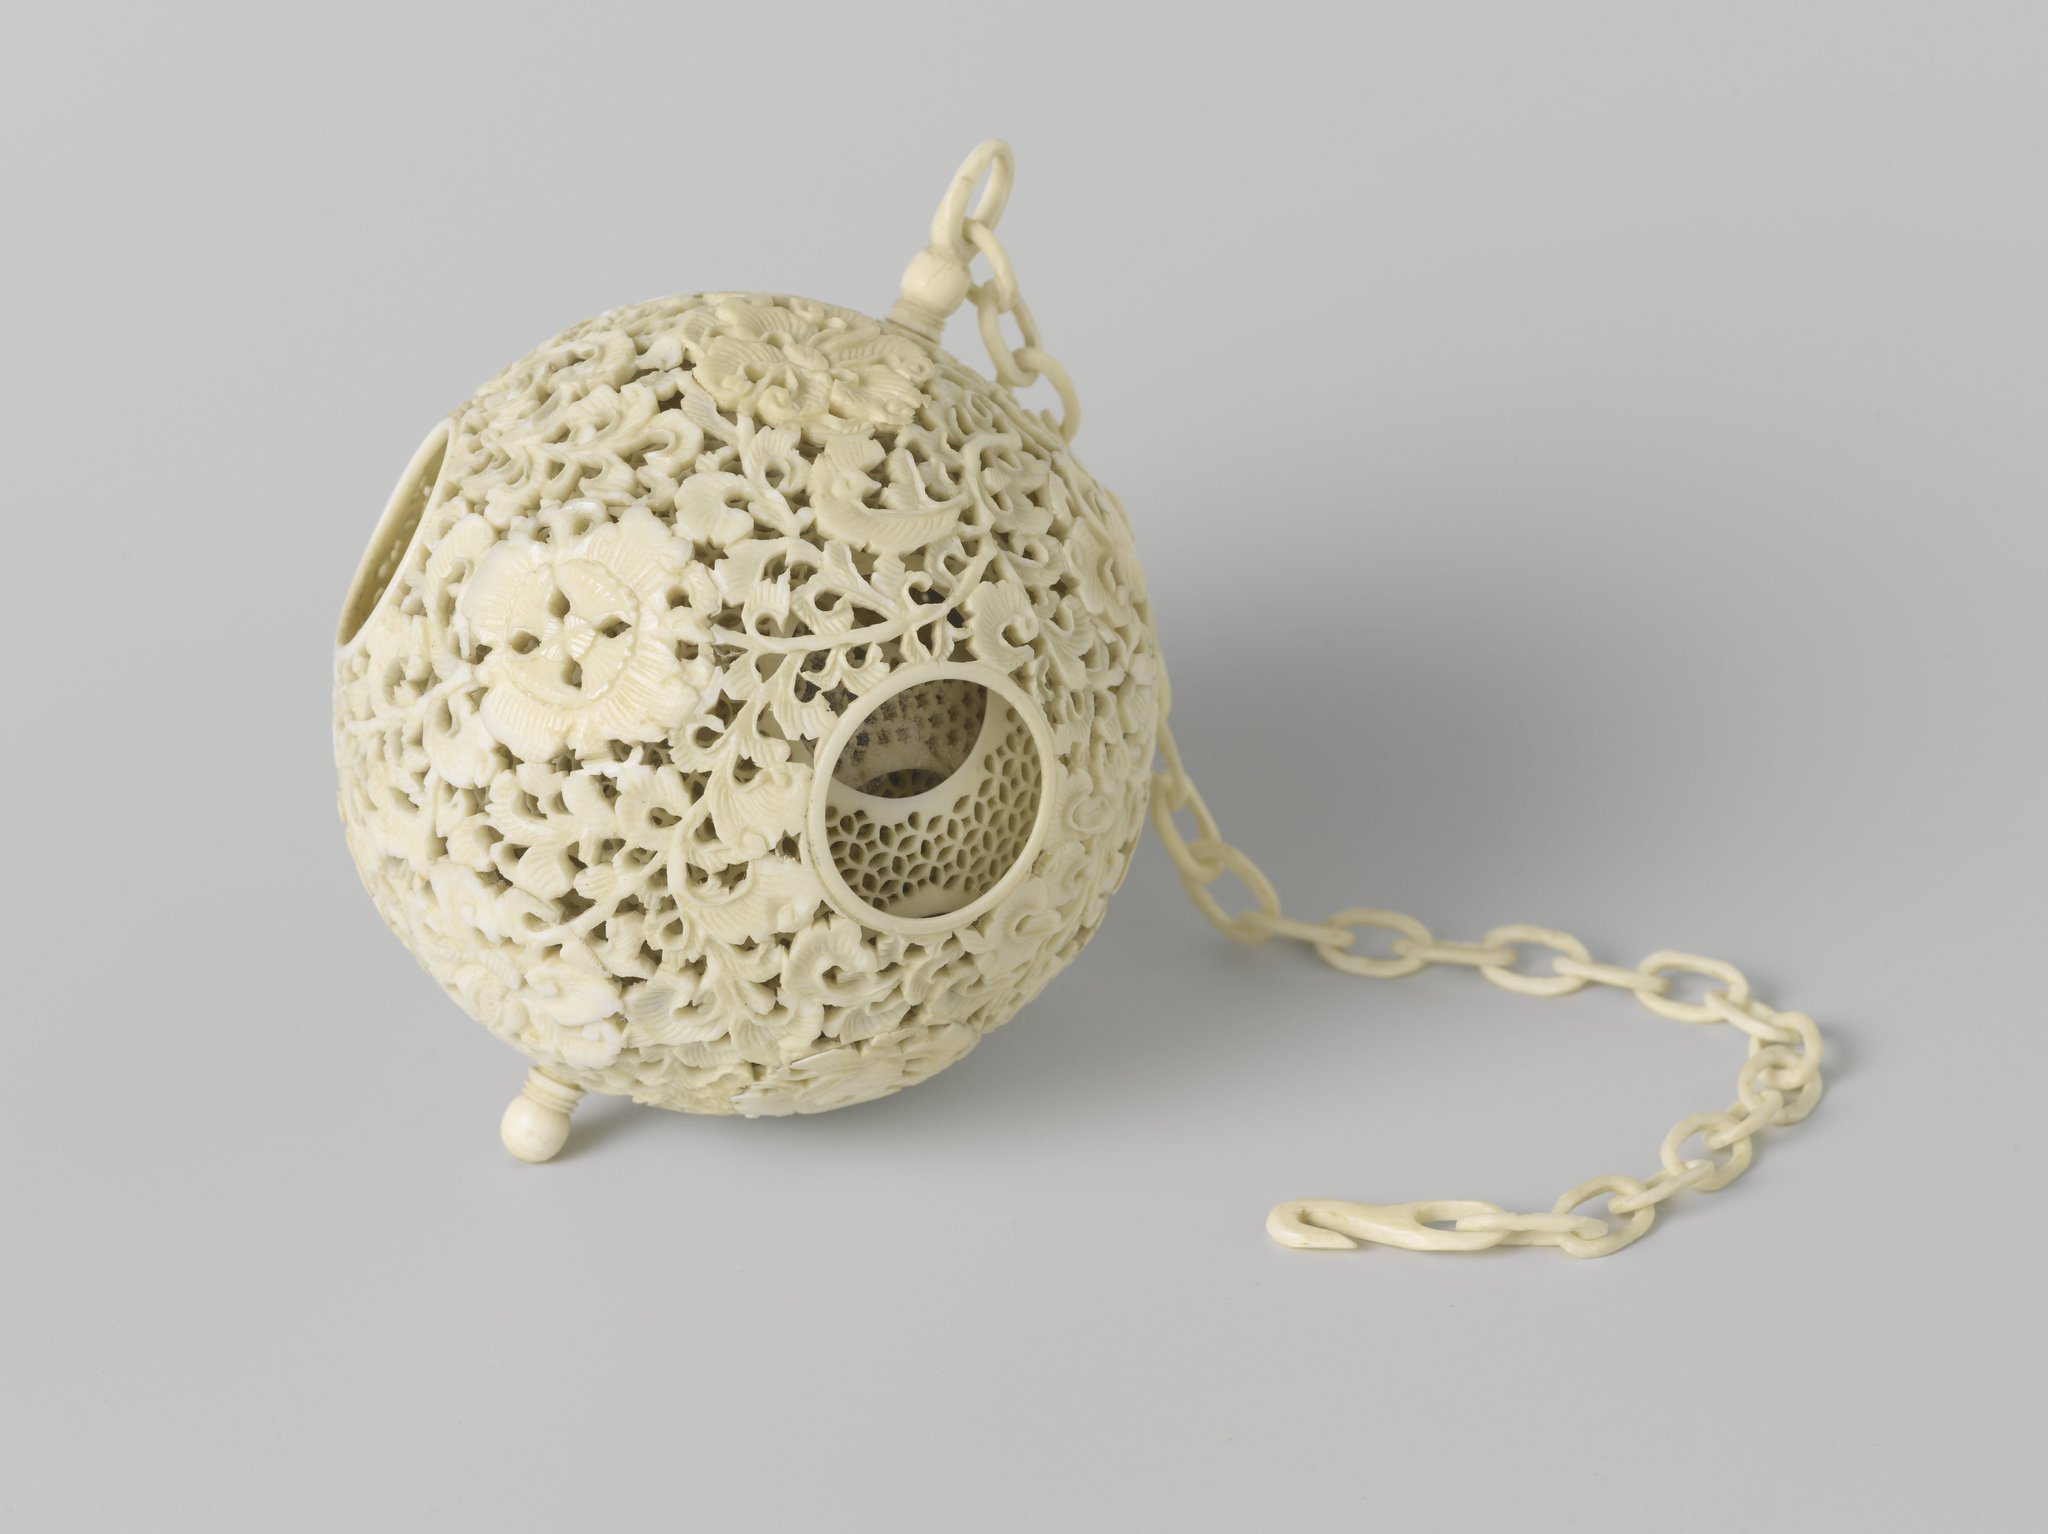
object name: bal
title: Bal met daarin acht (?) kleinere ballen met geometrische opengewerkte patronen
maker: Anonymous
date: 1770-1780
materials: ivory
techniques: cutting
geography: guangdong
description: Bal met daarin acht (?) kleinere ballen, gesneden uit één blok ivoor. De buitenste bol is voorzien van ranken in reliëf. Door drie ronde gaten zijn de binnen-ballen zichtbaar met verschillende geometrische opengewerkte patronen. Aan de bovenzijde een oog waaraan een ketting met ivoren schakels.